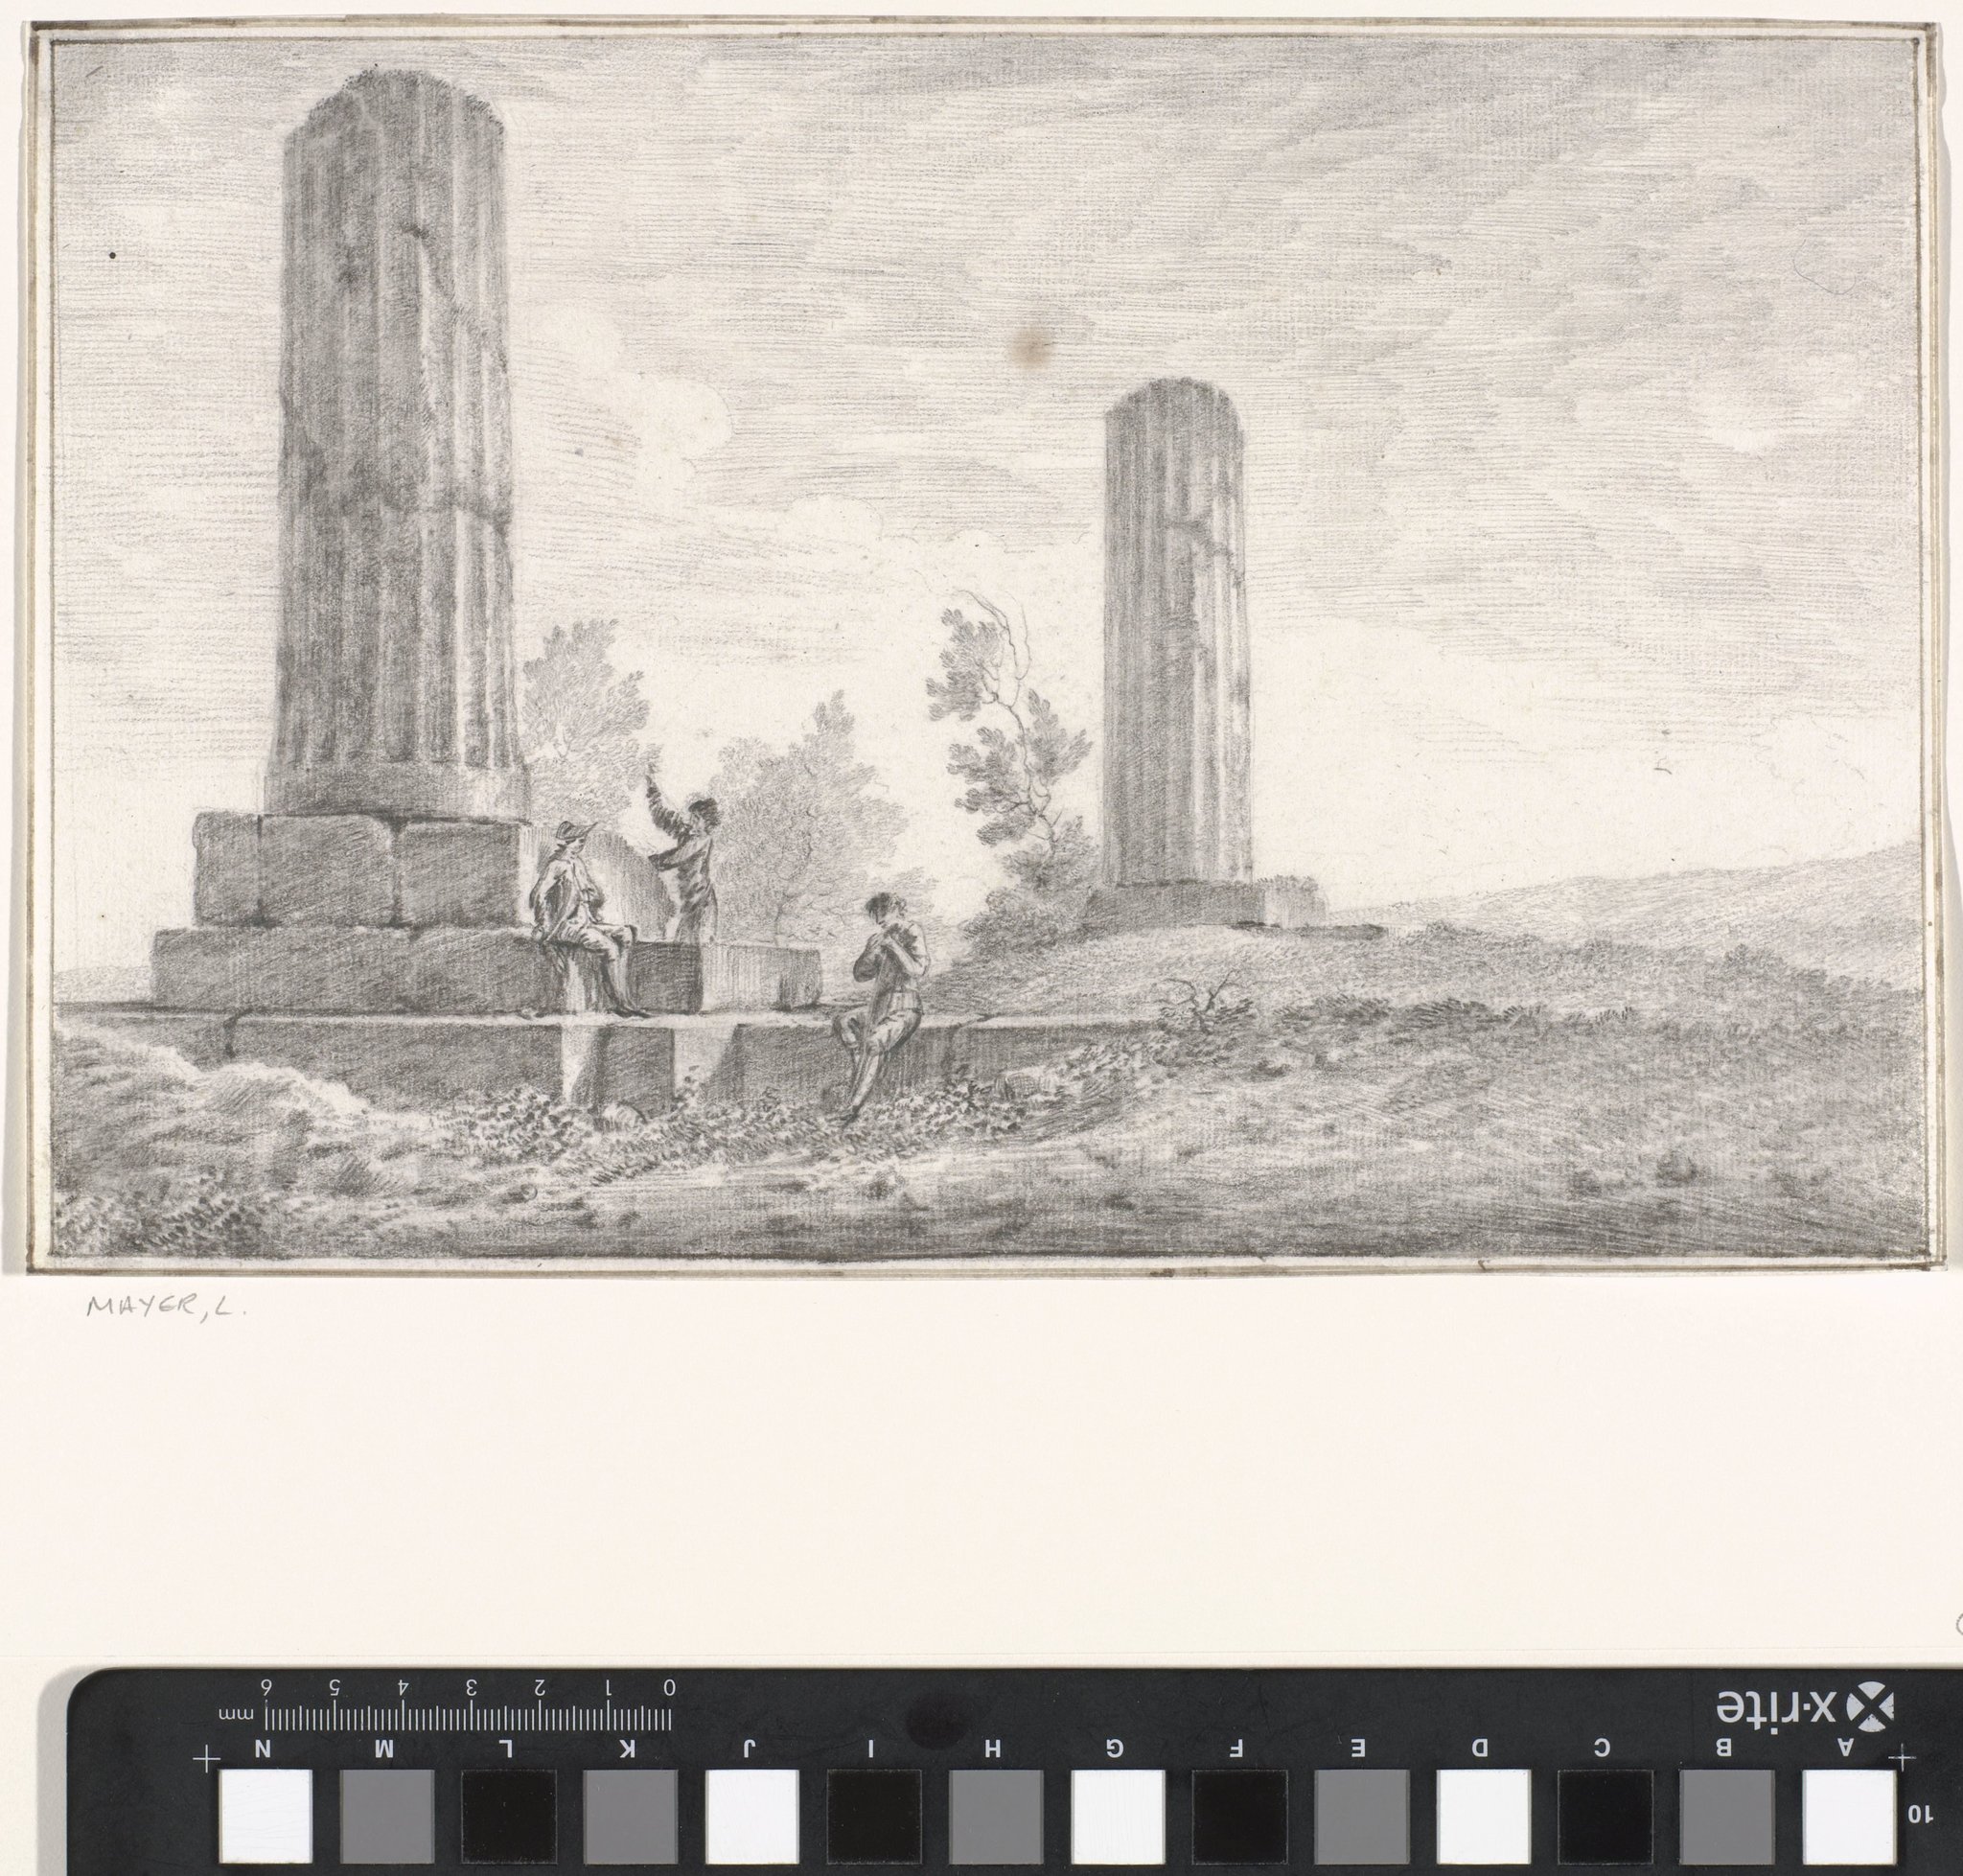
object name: drawing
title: Voyage en Italie, en Sicile et à Malte - 1778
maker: louis mayer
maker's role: draughtsman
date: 1778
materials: chalk, paper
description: Tekening uit het album 'Voyage en Italie, en Sicile et à Malte', 1778.